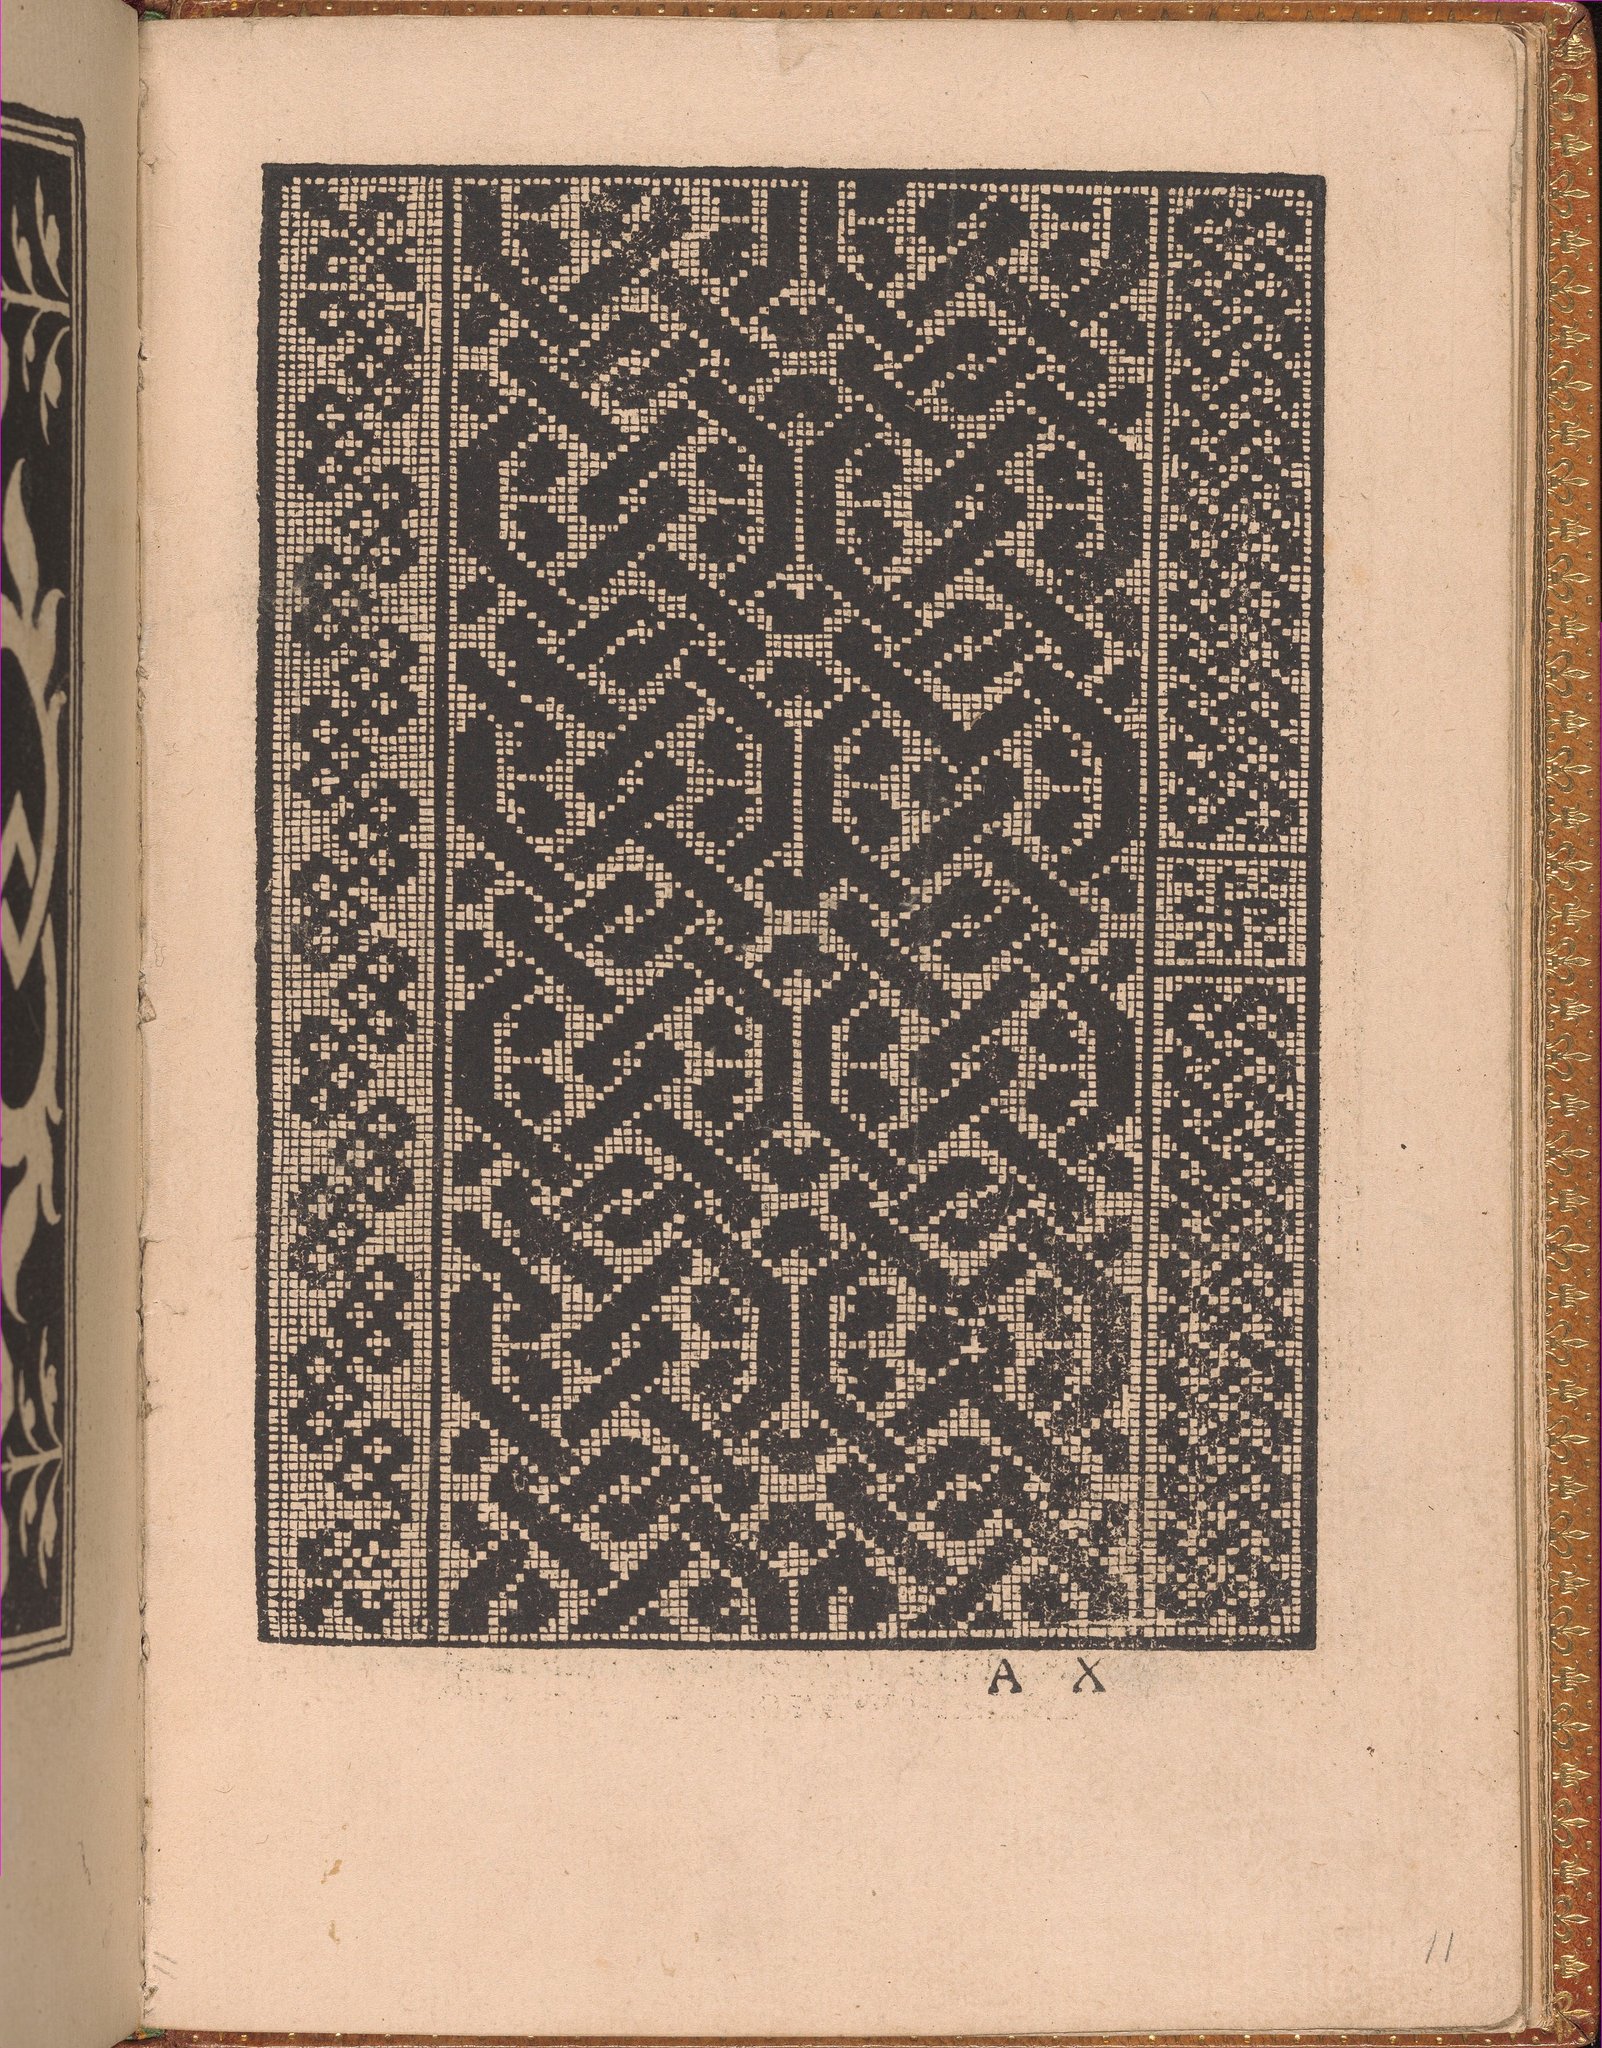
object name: book print ornament architecture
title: Convivio delle Belle Donne, page 11 (recto)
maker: nicolò zoppino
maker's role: publisher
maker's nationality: italian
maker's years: 1478-1544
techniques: woodcut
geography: italy